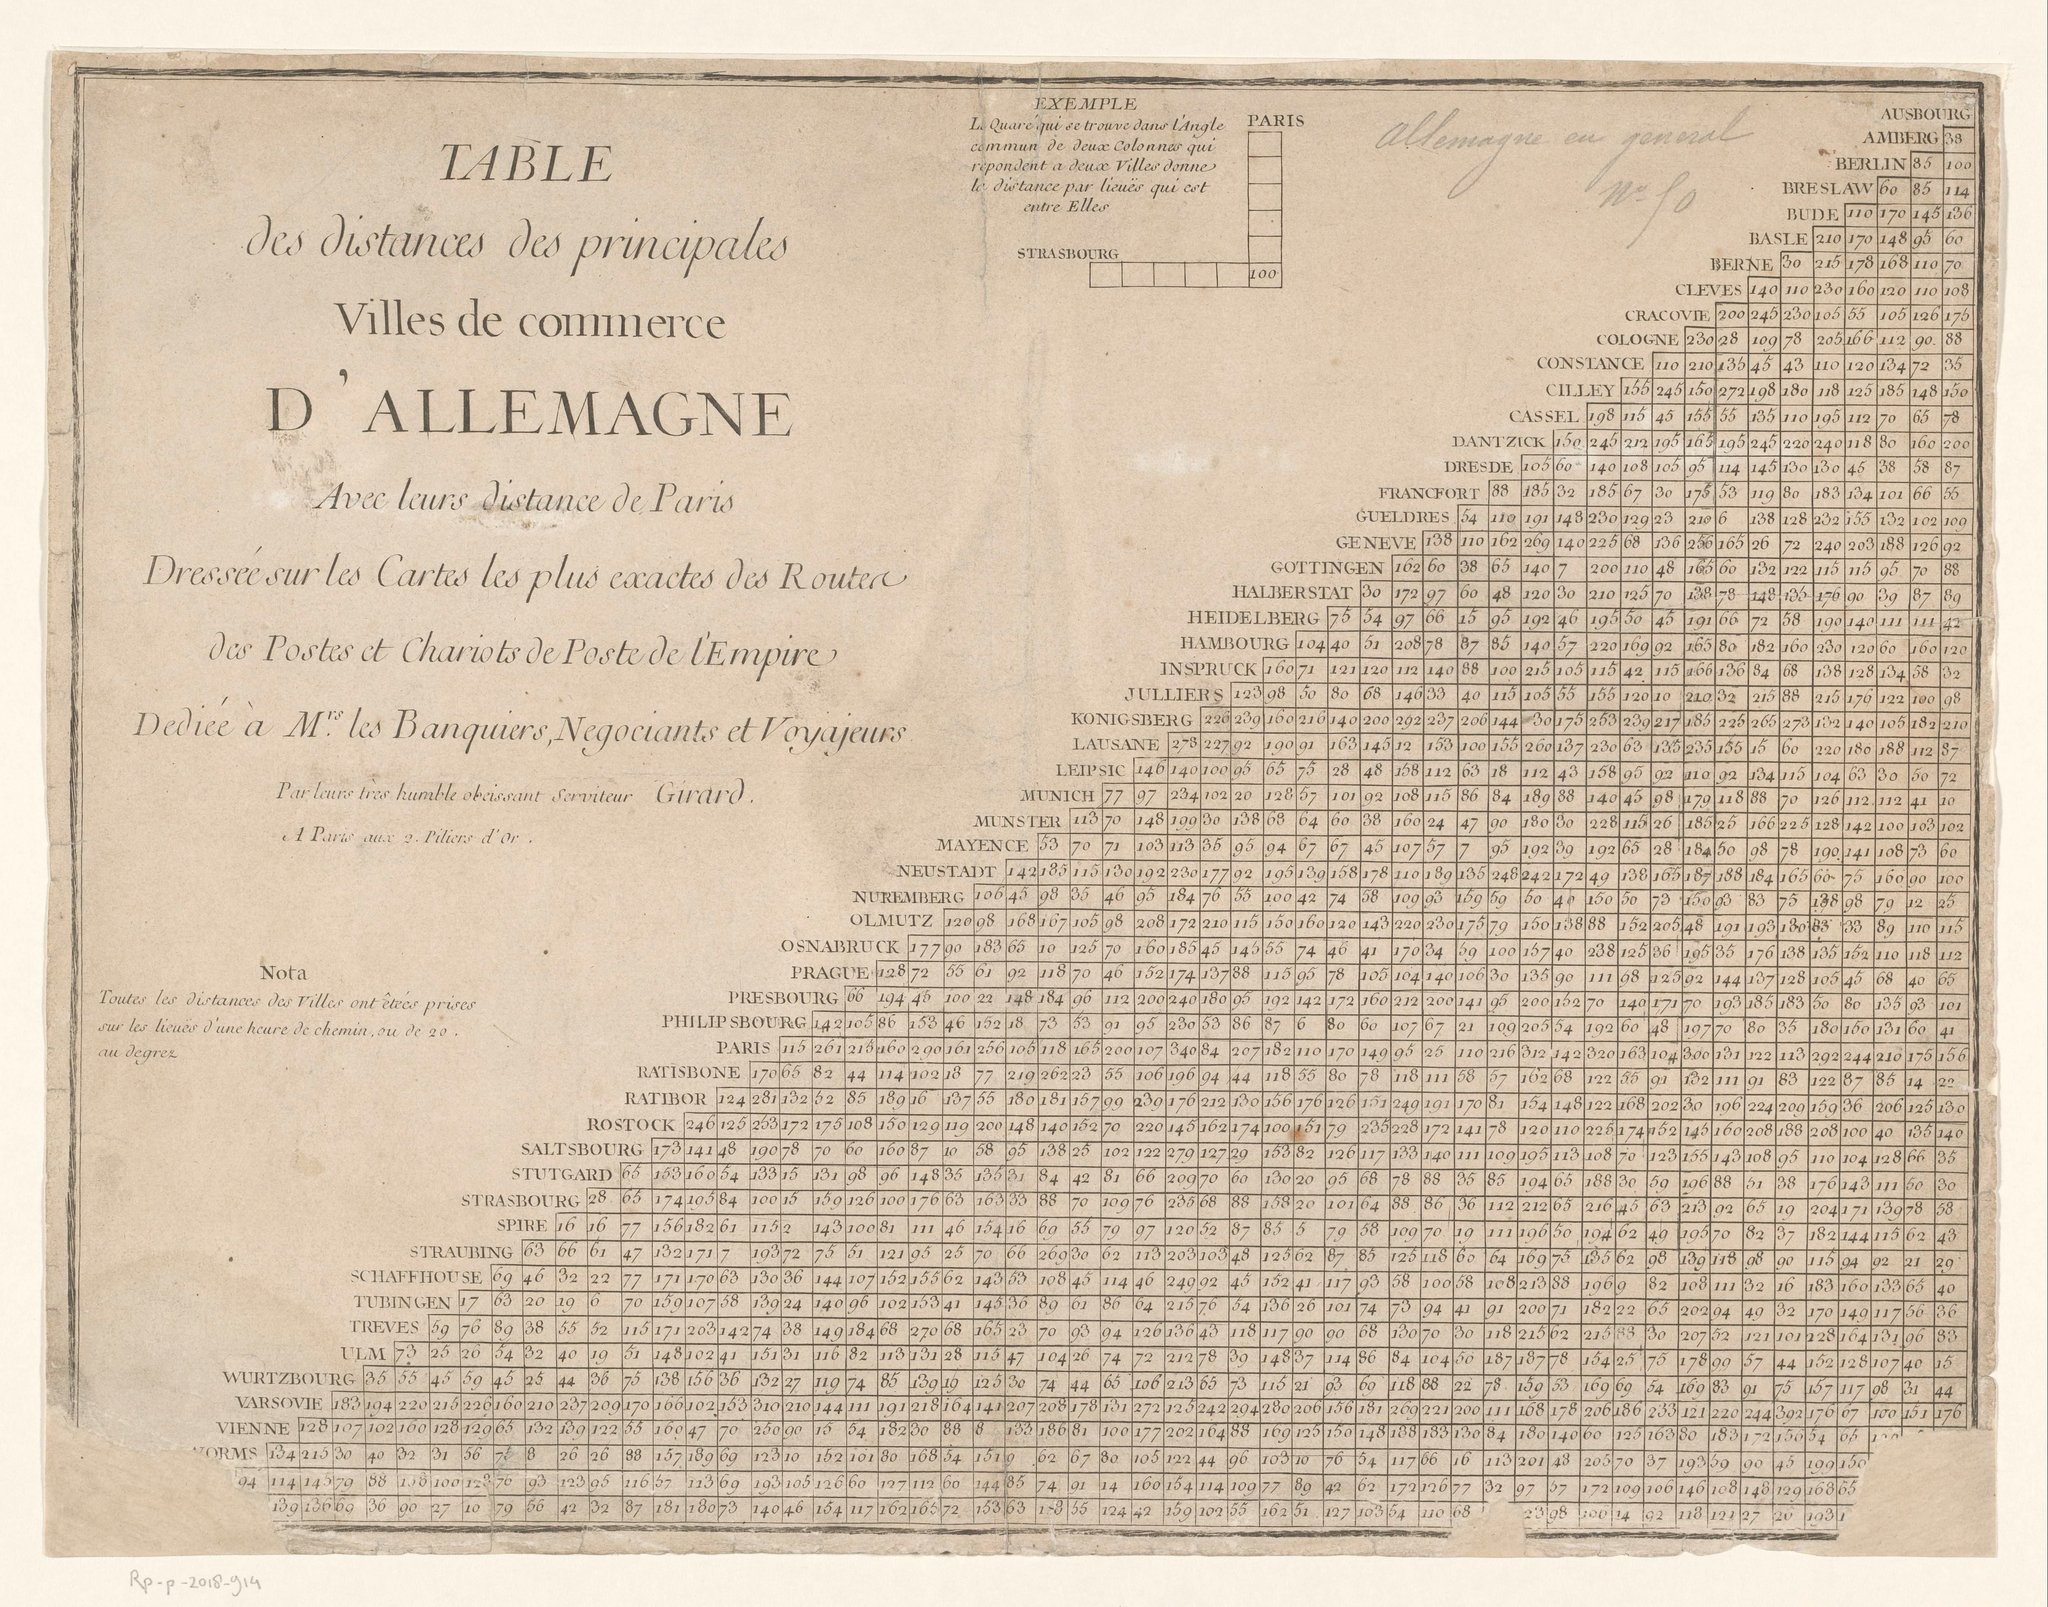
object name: print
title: Tabel met de afstanden tussen de steden van Duitsland en Parijs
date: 1650-1703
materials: paper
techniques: engraving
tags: coat of arms (as symbol of the state, etc.) (+ city; municipal), germany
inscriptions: collector's mark: Lugt 2228